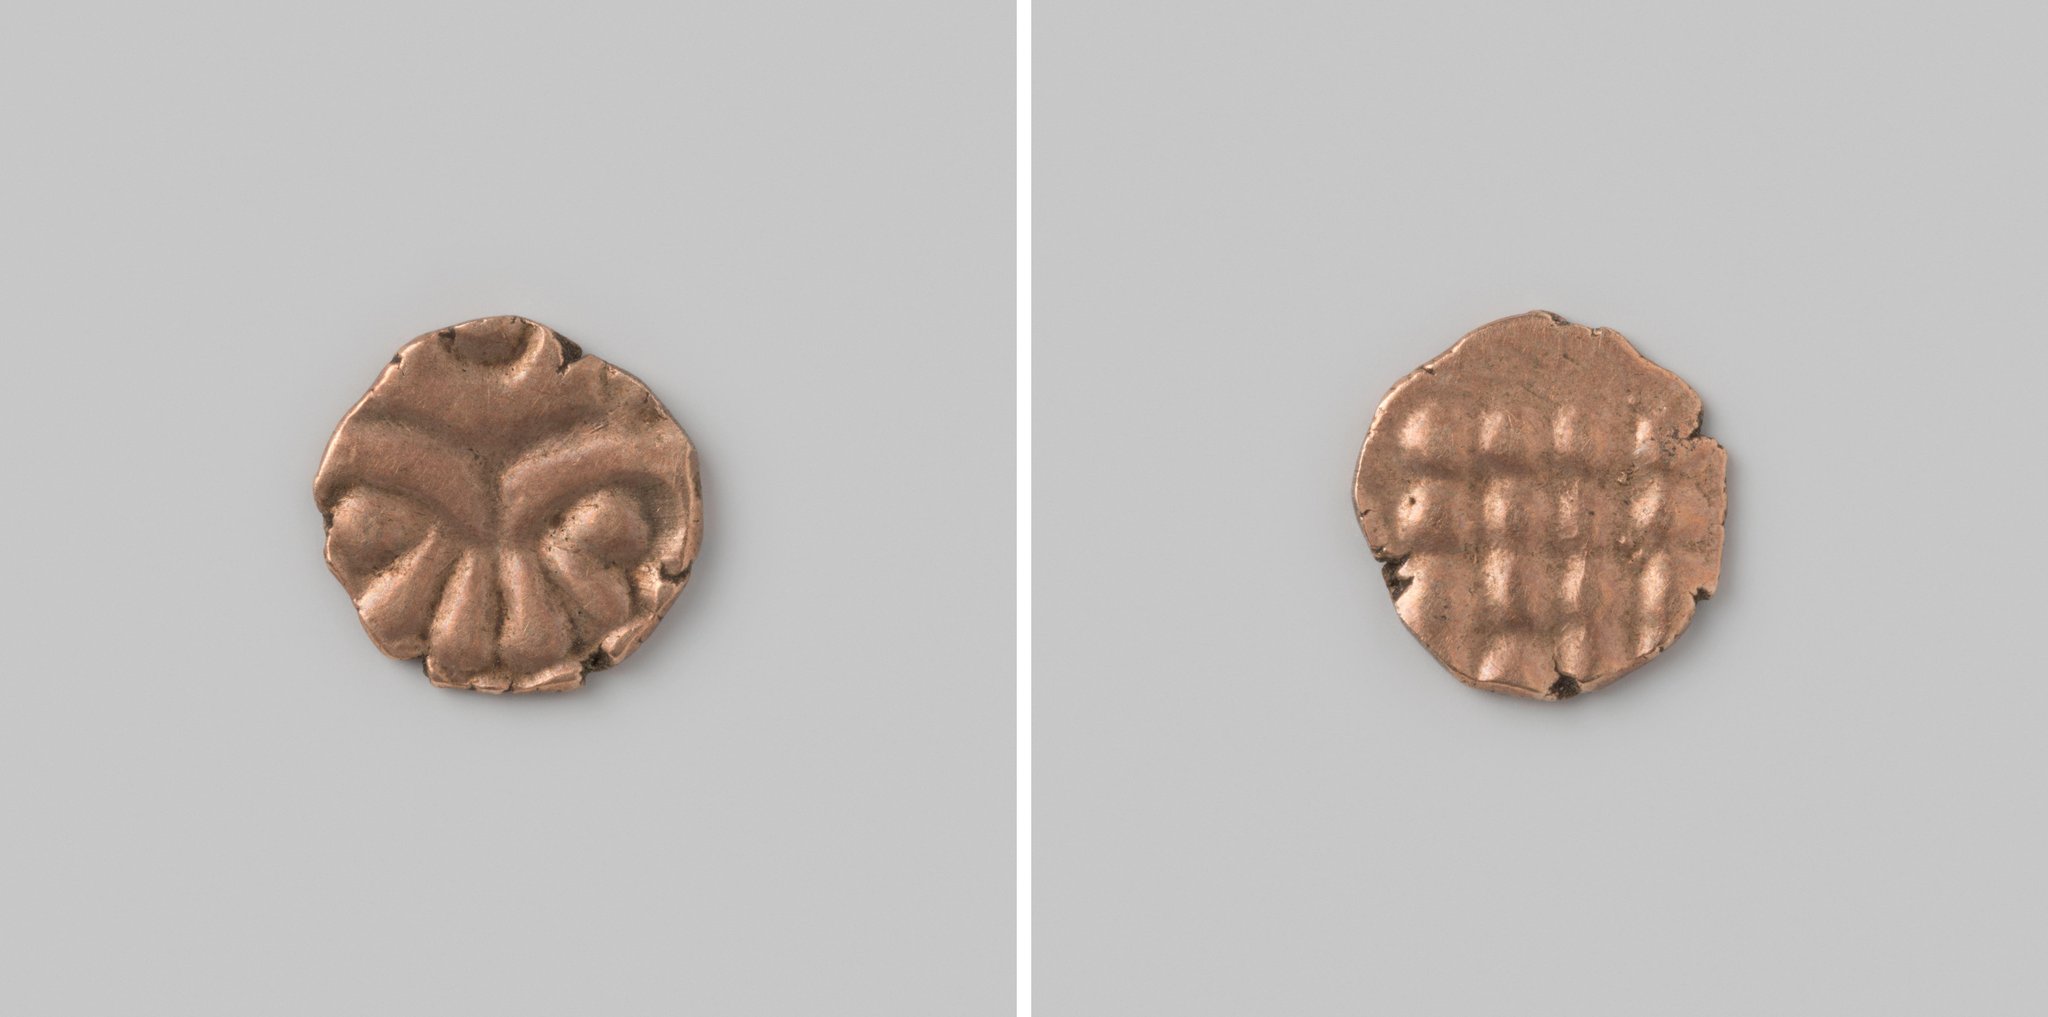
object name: coin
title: Gouden fanam uit Tinnevelli in India onder de Nayakas,1520-1736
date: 1520-1736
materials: gold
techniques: striking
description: Gouden munt. Voorzijde: aanziende godheid [?]. Keerzijde: versiering, waaronder drie rijen van elk vier stippen.